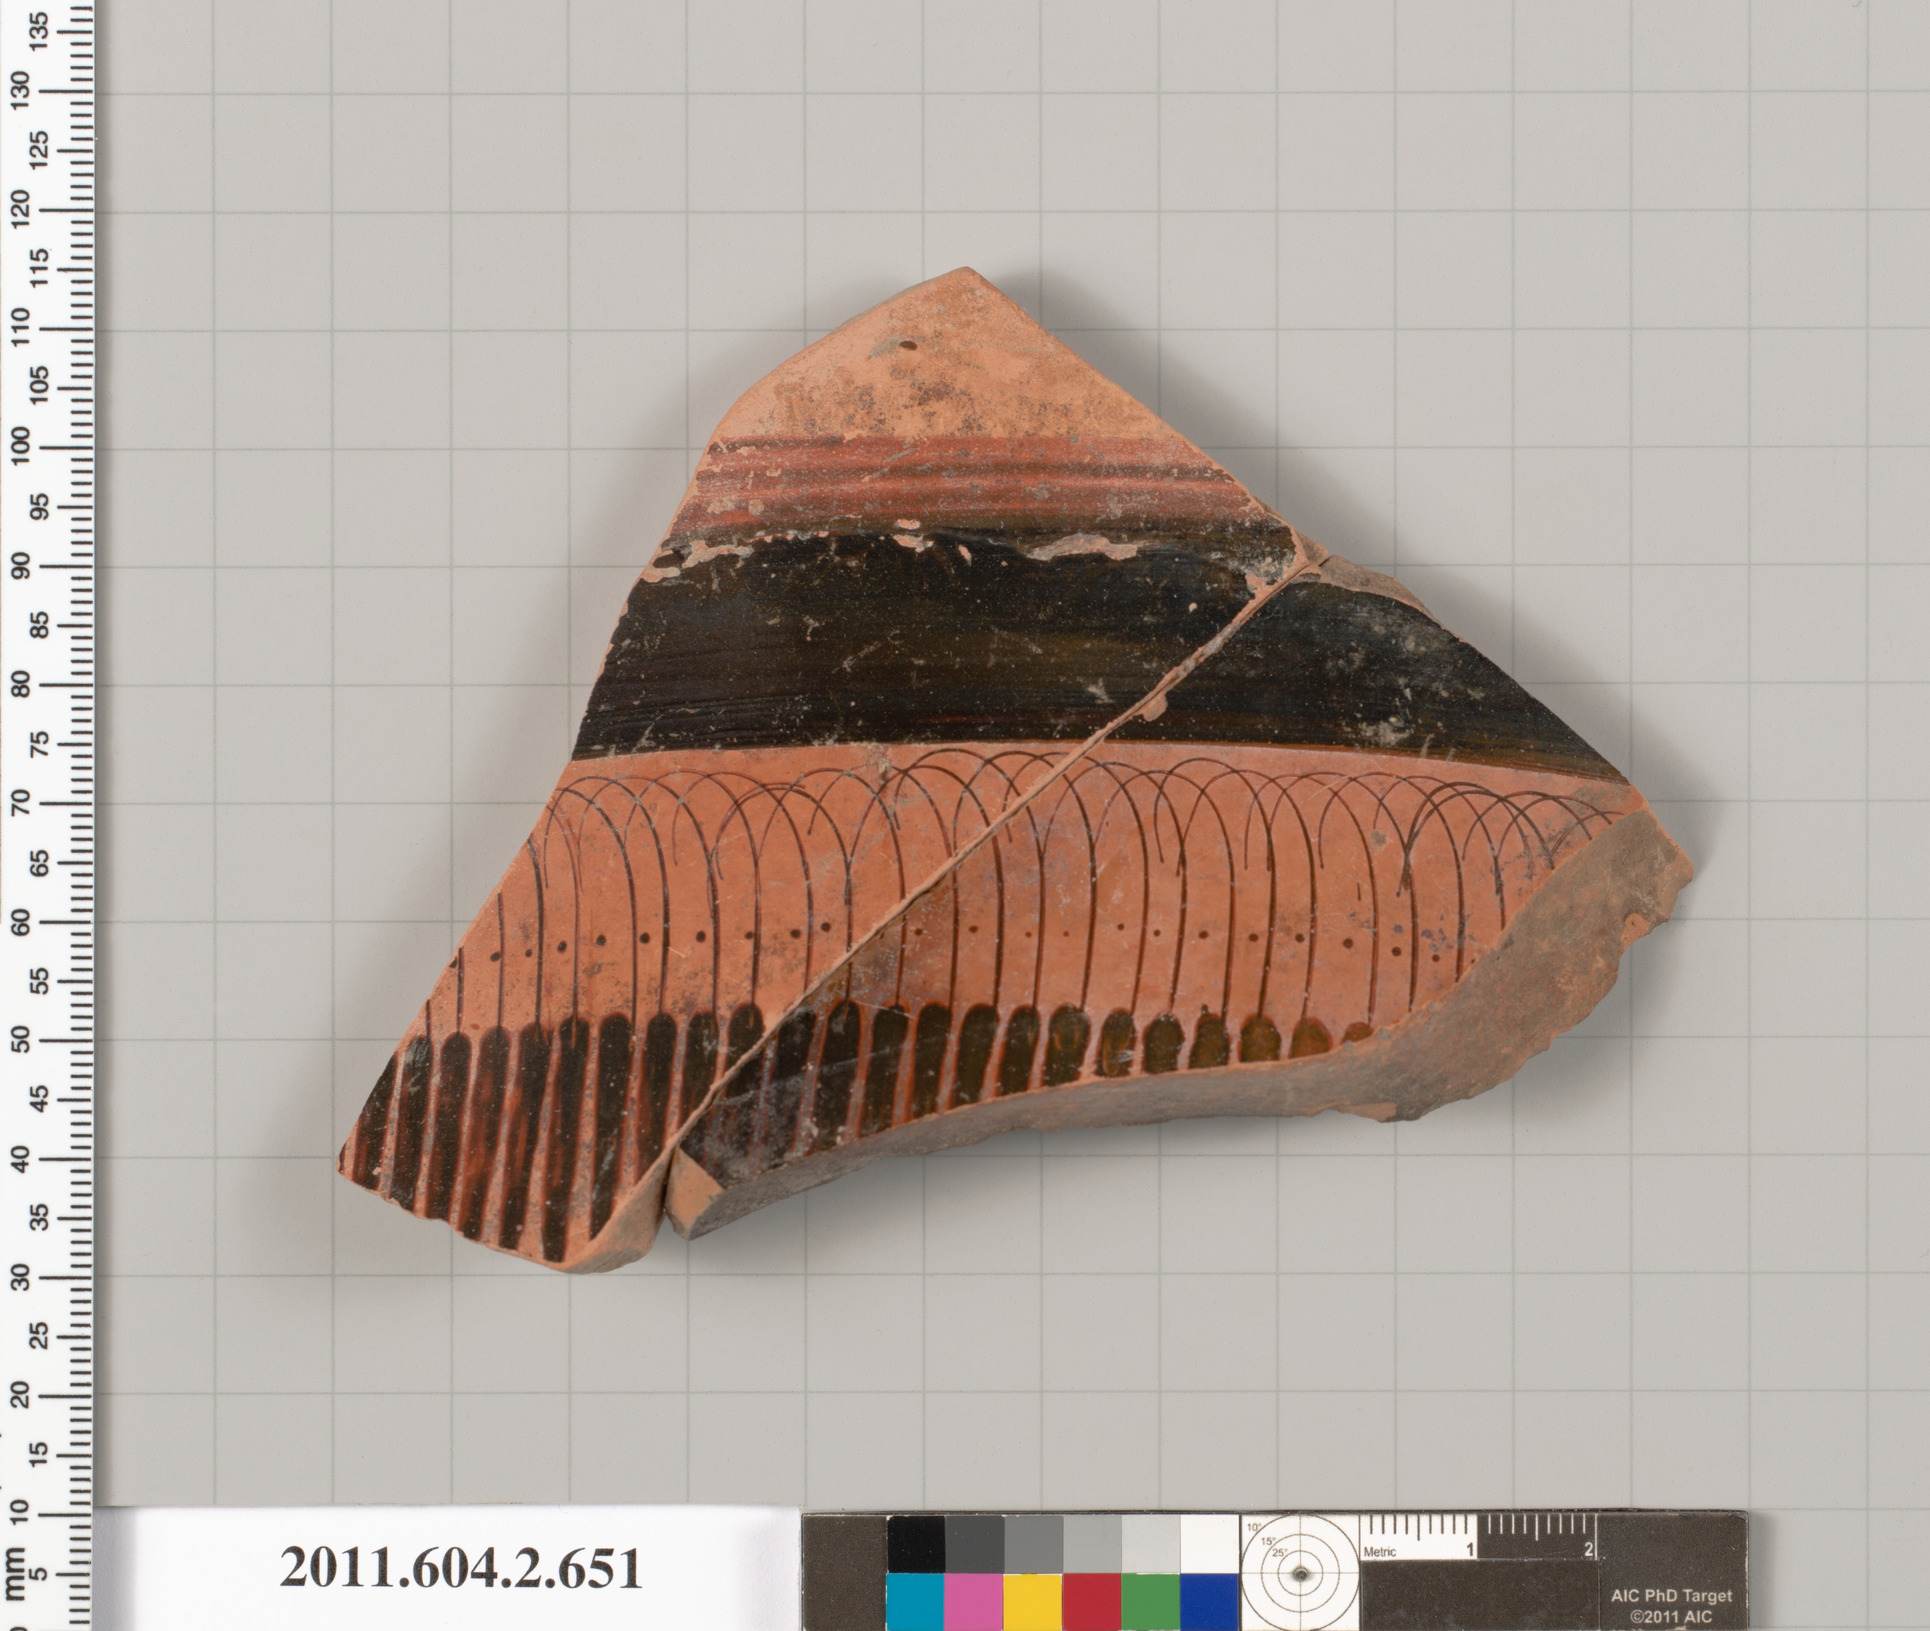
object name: column krater fragment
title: Terracotta fragment of a column-krater (bowl for mixing wine and water)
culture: greek, attic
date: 475-451 BCE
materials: terracotta